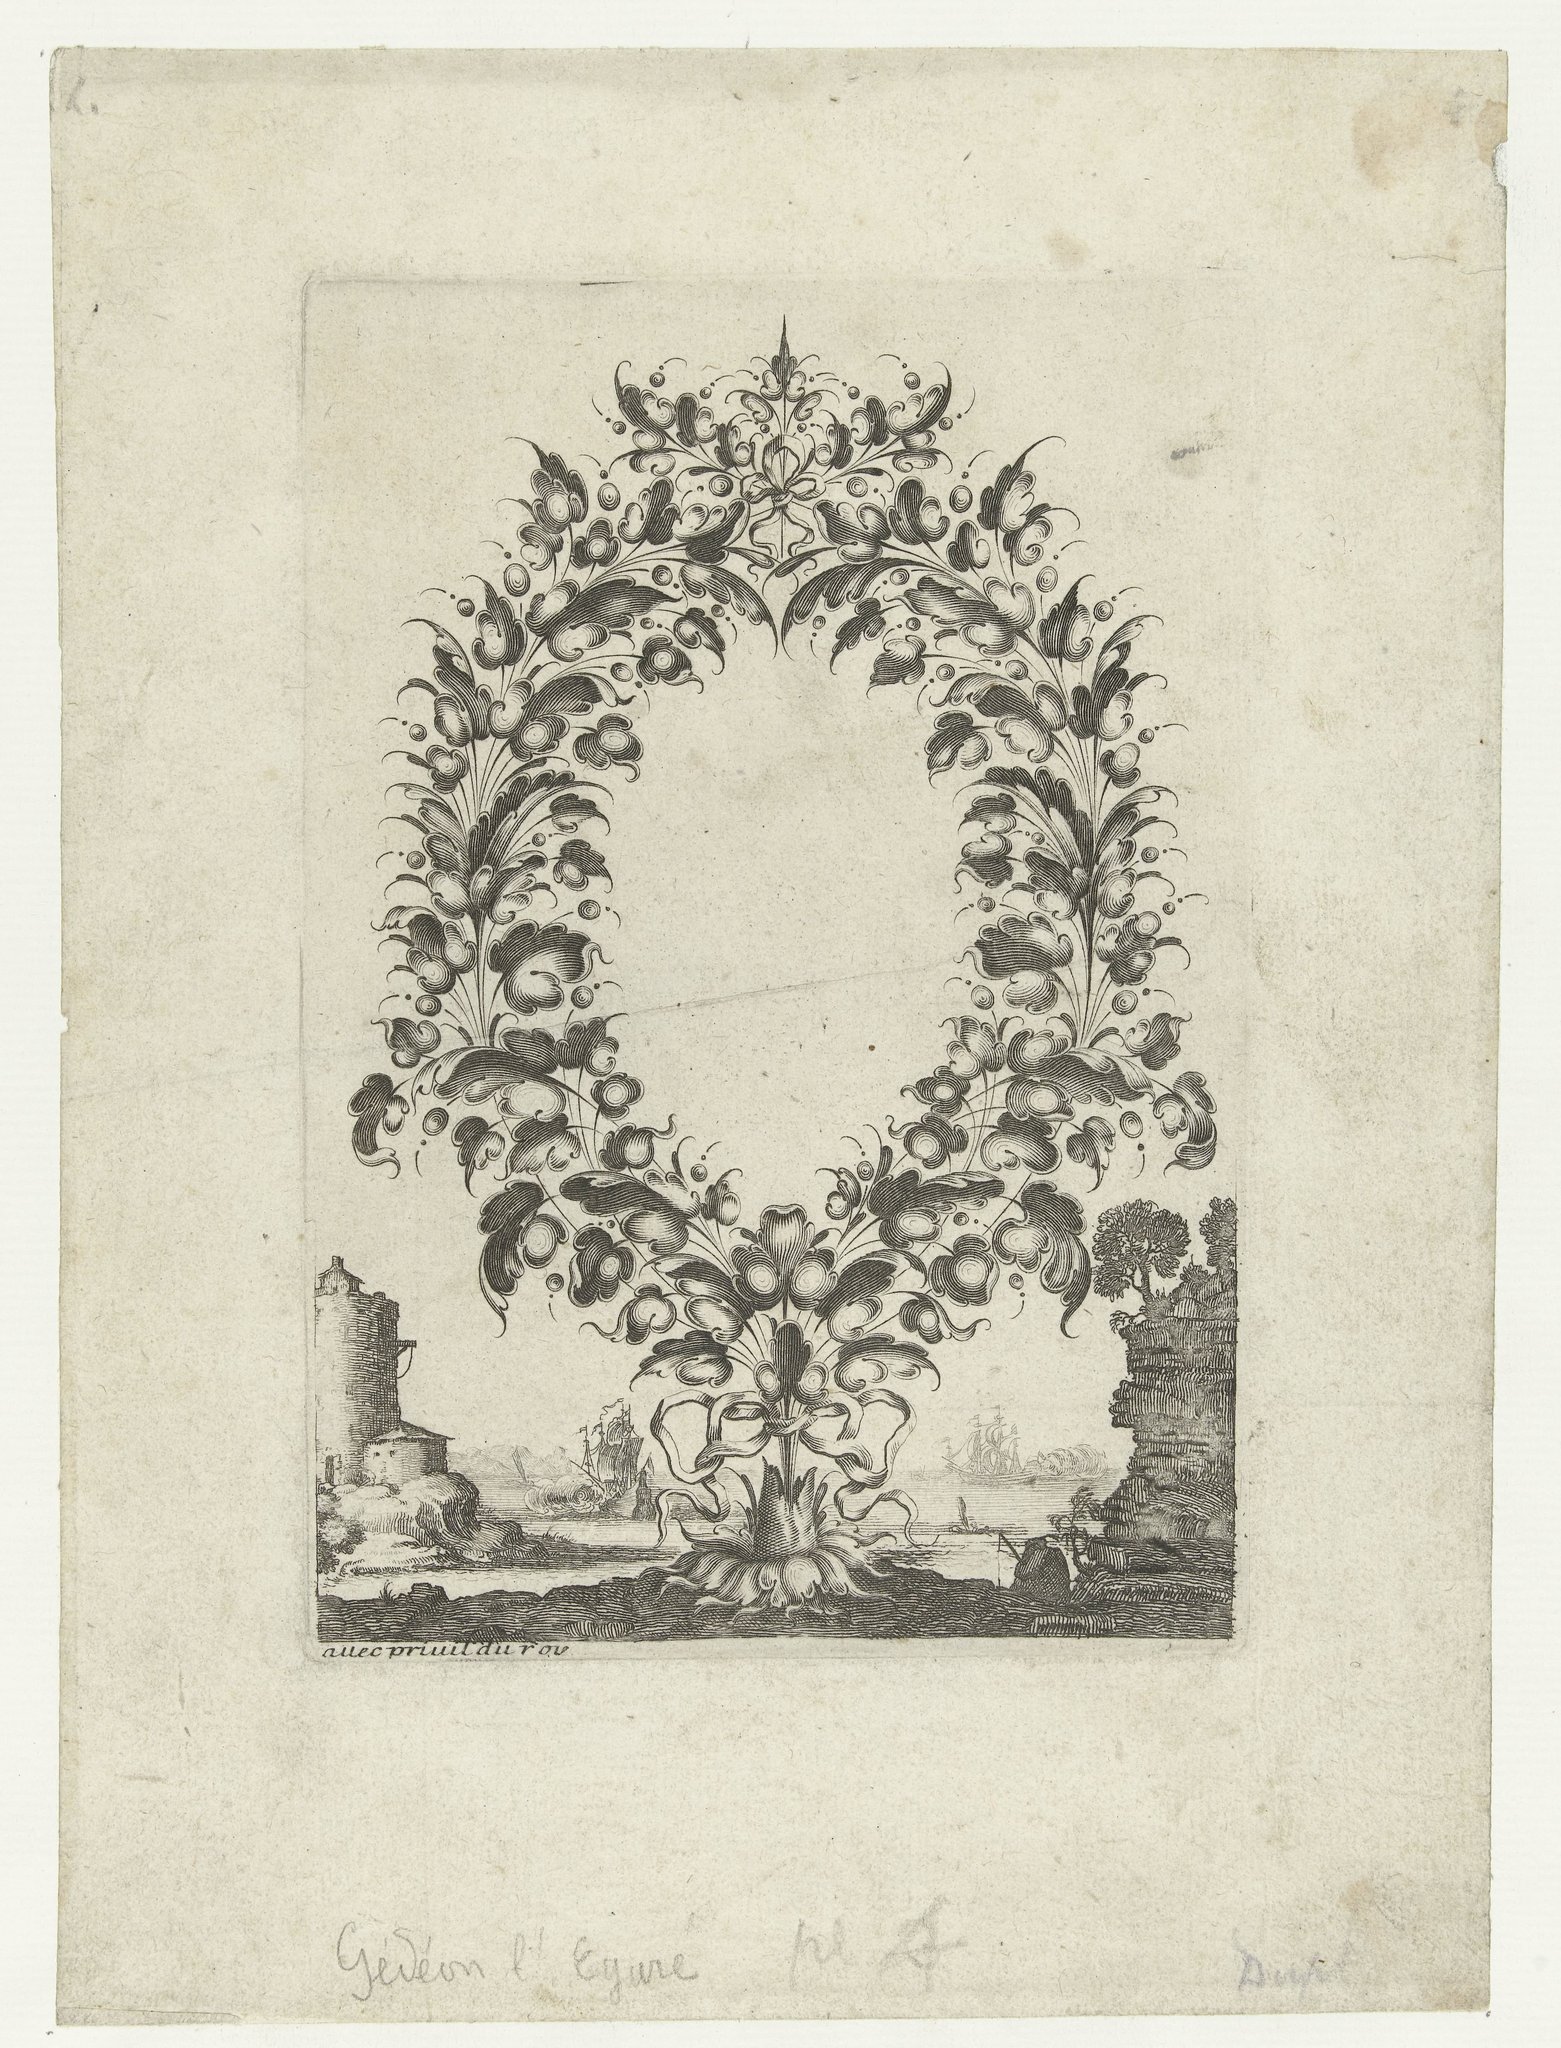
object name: ornament print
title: Liure de Feuilles d'Orfeurerie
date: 1640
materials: paper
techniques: engraving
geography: paris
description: Boeket in de vorm van een krans, rechtsonder een rots met een visser. Uit serie van 7 bladen met edelsmidsboeketten met een landschap op de achtergrond. Eerste editie.